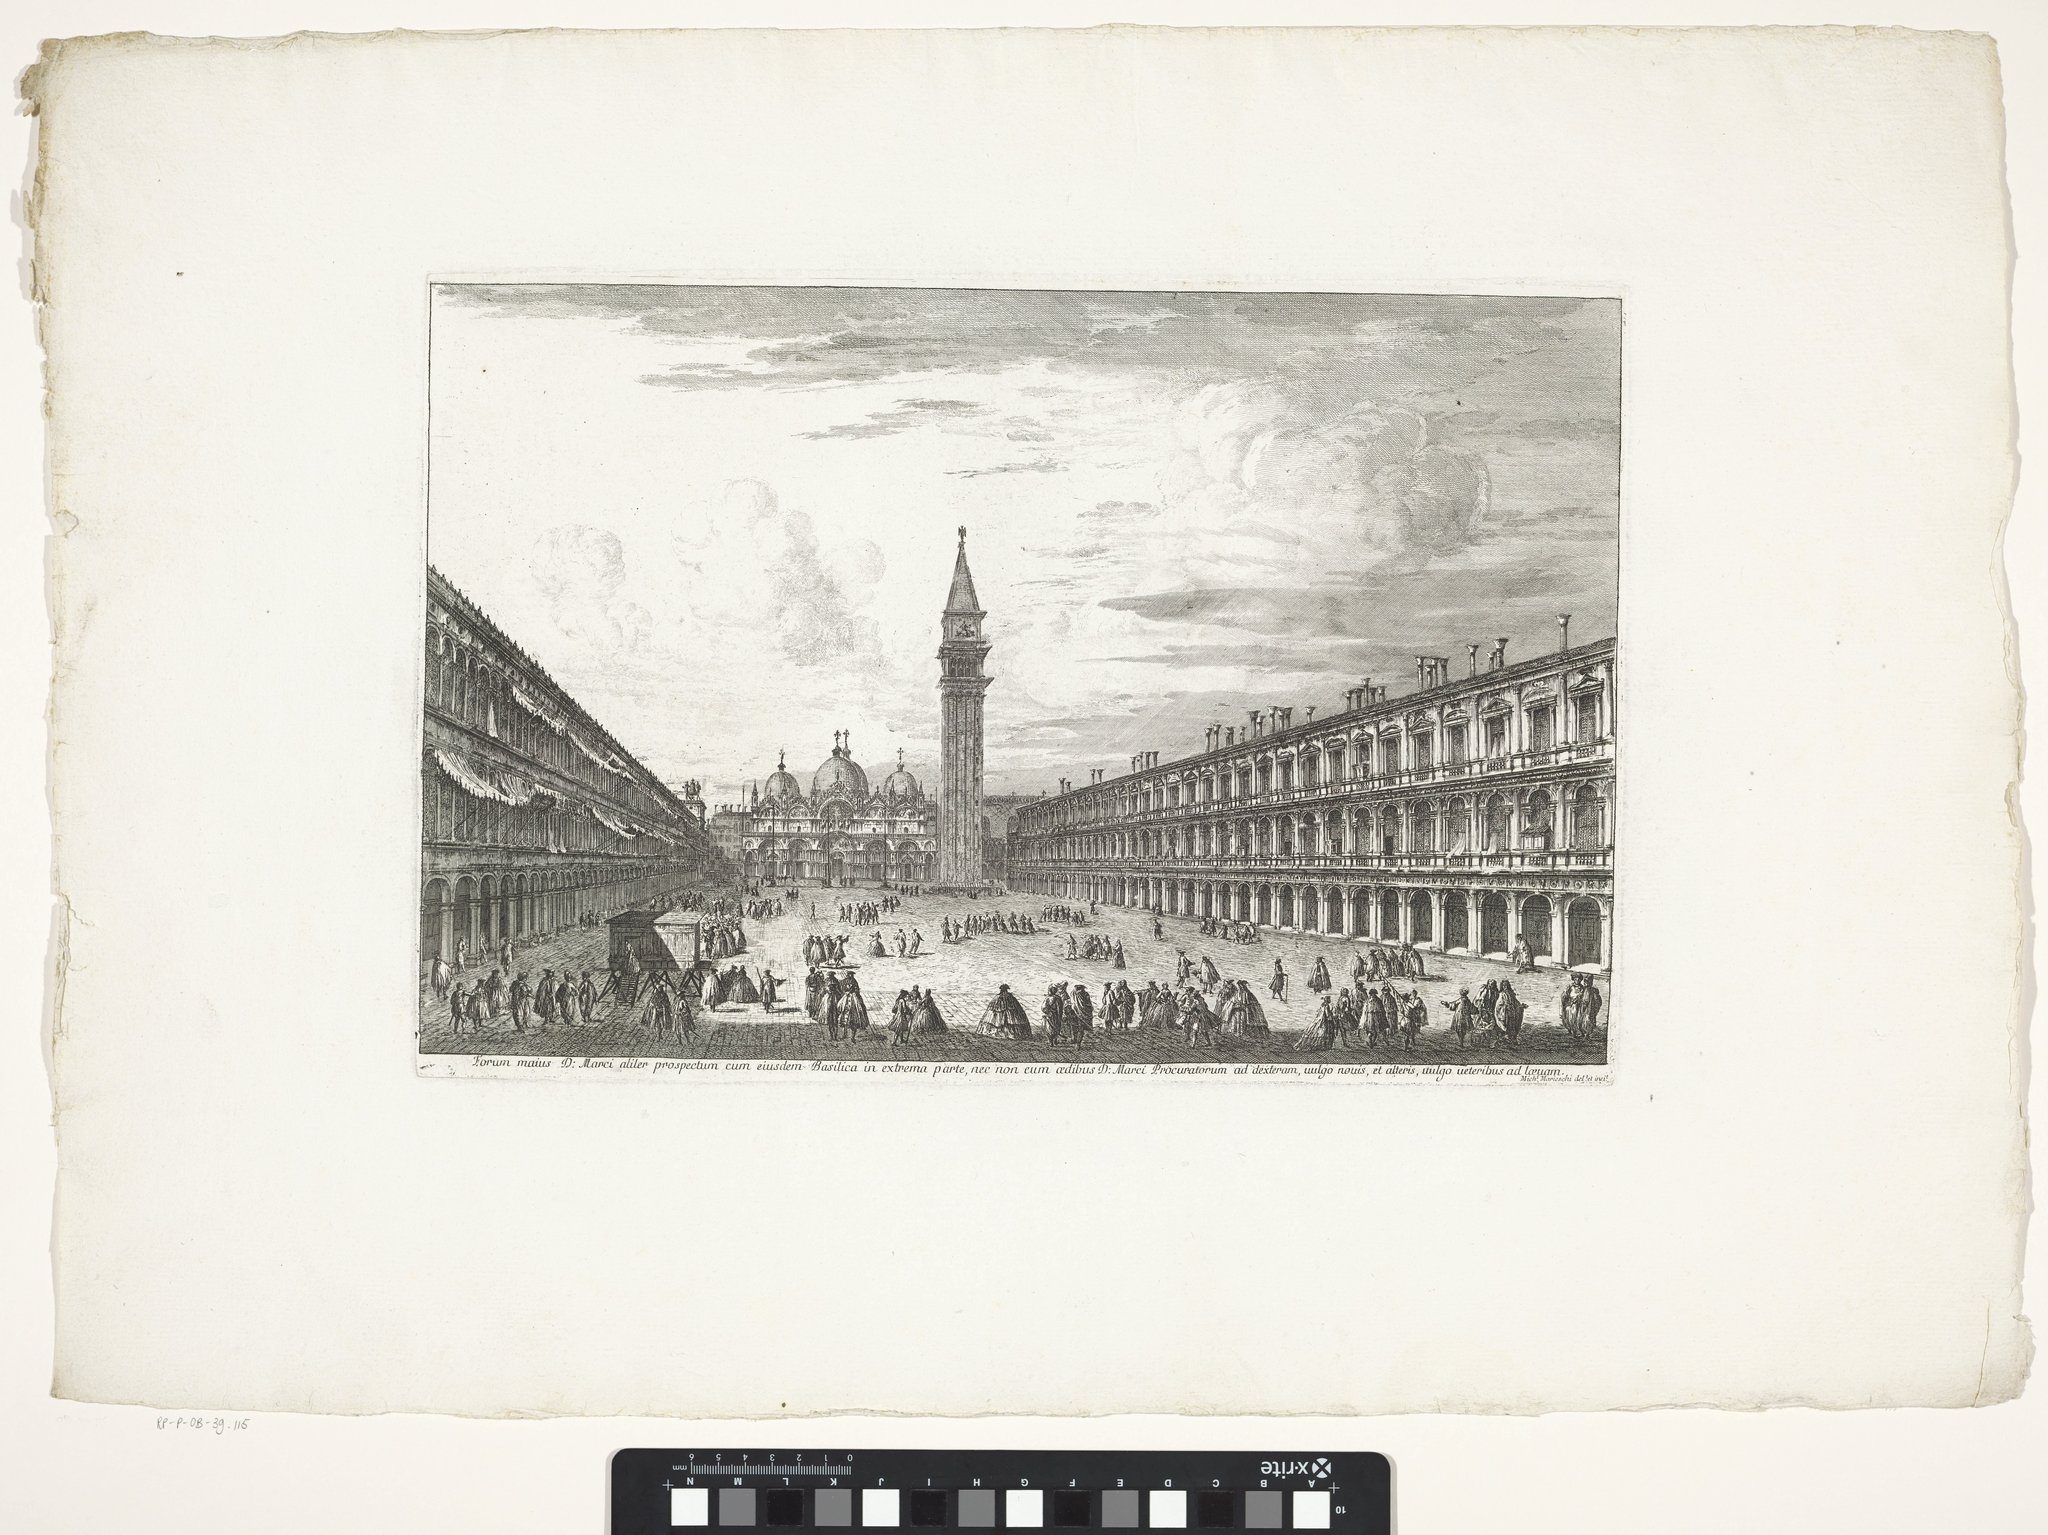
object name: print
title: Magnificentiores selectioresque urbis Venetiarum prospectus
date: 1741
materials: paper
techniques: engraving, etching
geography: venice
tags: square, place, circus, etc., city-view, and landscape with man-made constructions, church (exterior), venice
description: Gezicht op het San Marco Plein te Venetië. Op de achtergrond de San Marco.